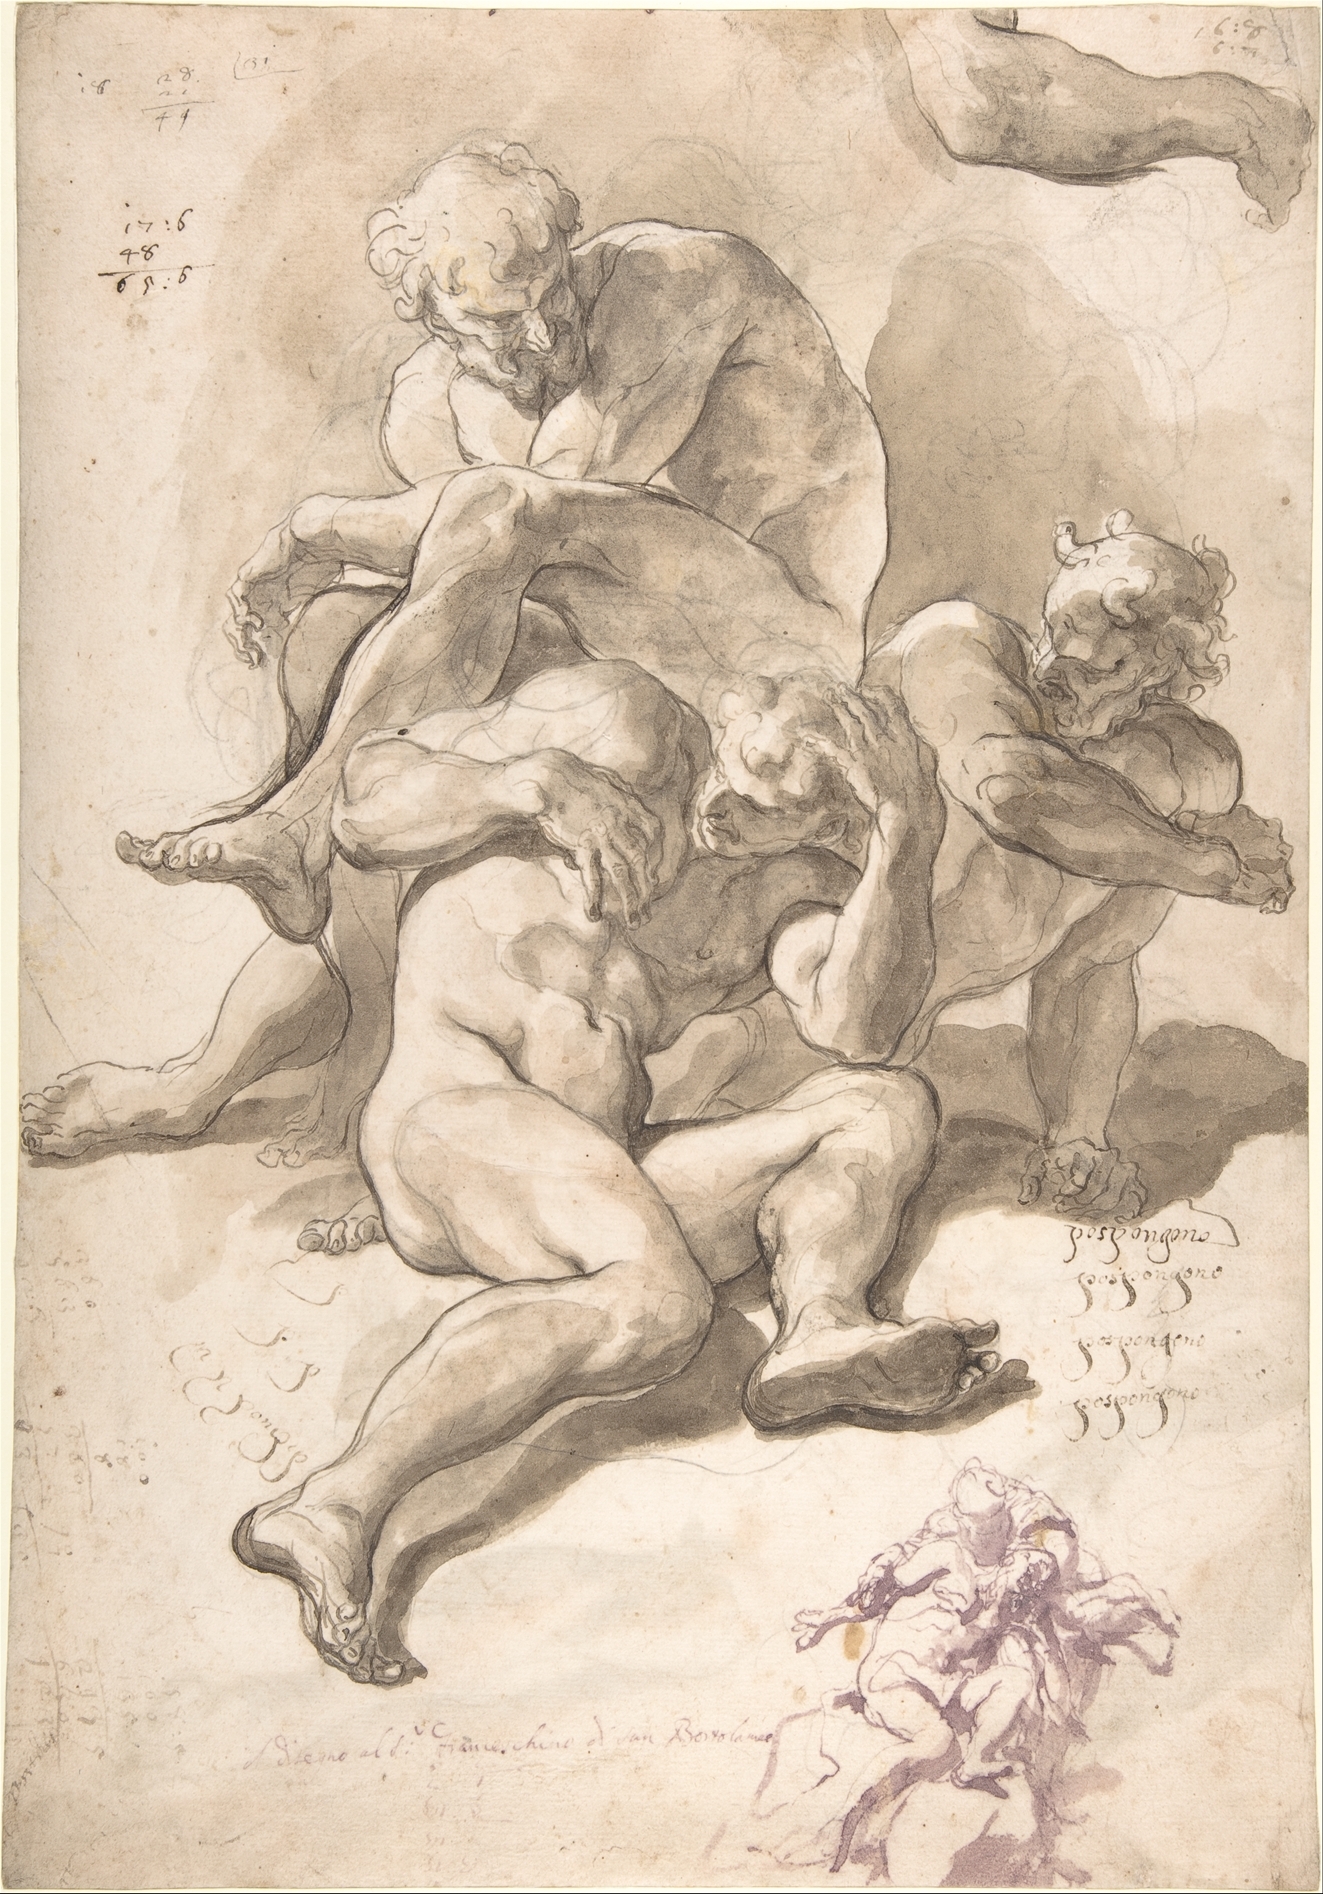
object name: drawing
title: Studies of Three Naked Men, a Right Arm and a Nude Figure Supported by Another (recto); Studies of a Figure with Left Arm Upraised, a Leg, and Putti with Foliage (verso)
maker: paolo pagani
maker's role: artist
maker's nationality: italian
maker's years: 1661-1716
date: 1700-1710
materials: chalk, ink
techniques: brush, pen, wash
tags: male nudes